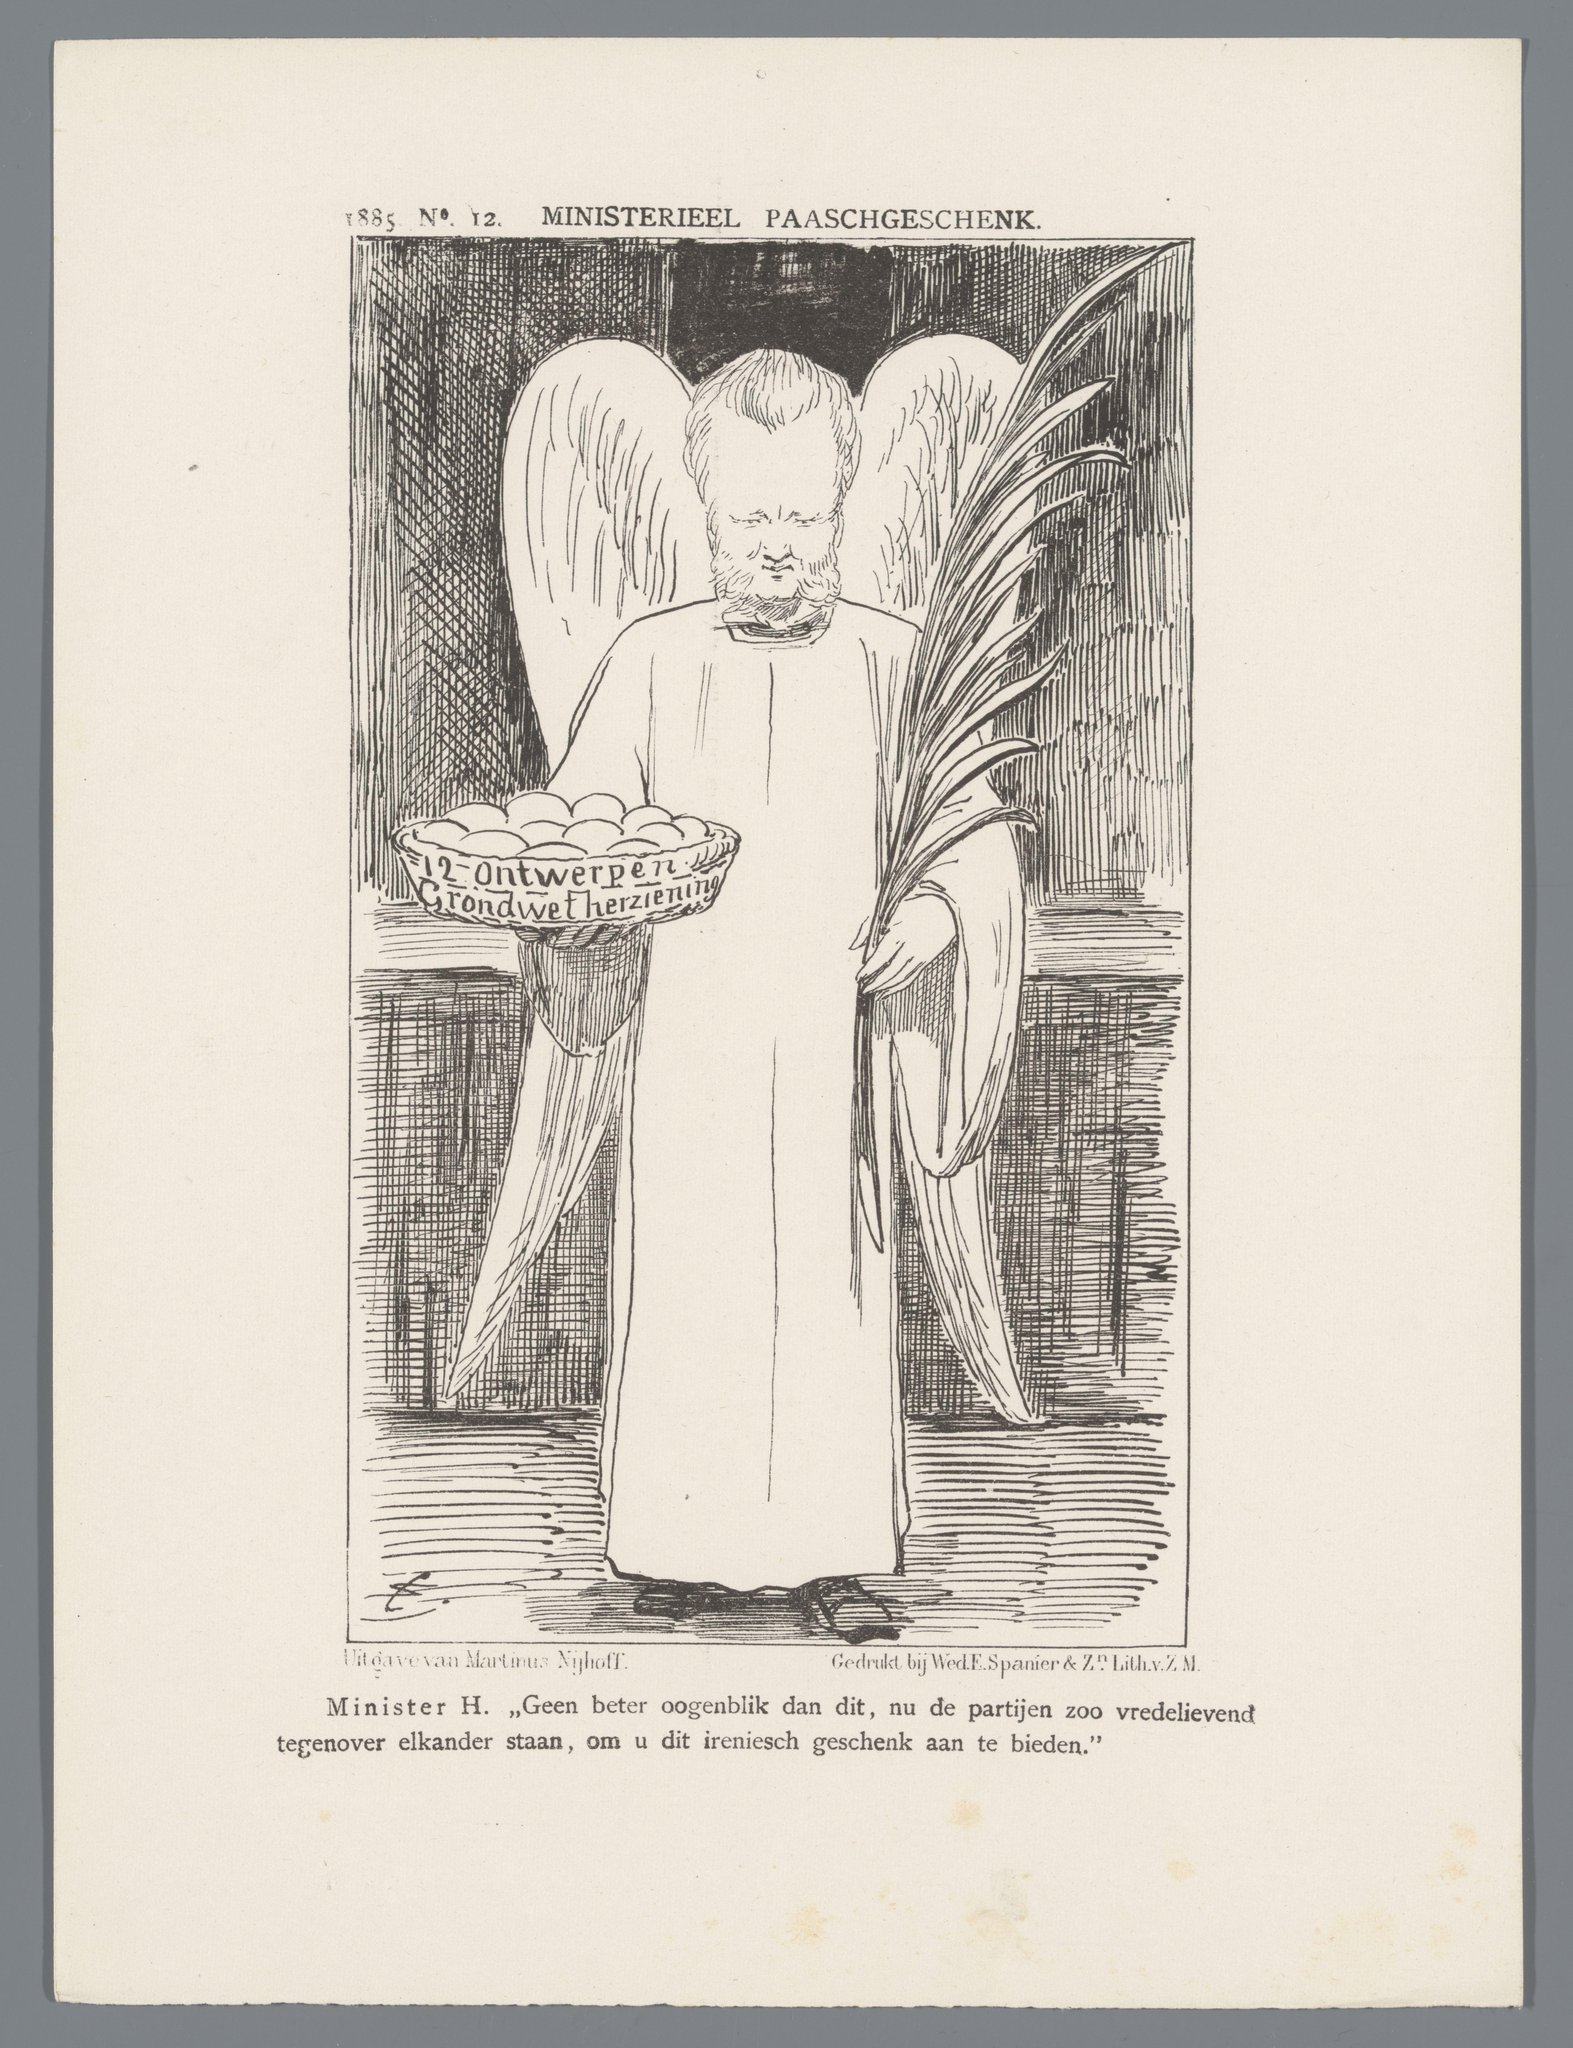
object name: cartoon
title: Spotprent met Heemskerk als engel, 1885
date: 1885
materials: paper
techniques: lithograph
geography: netherlands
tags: amsterdam, the hague, politician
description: Spotprent met minister Heemskerk als engel met Pasen. Plaat verschenen bij het weekblad De Nederlandsche Spectator, nr. 12, 1885.